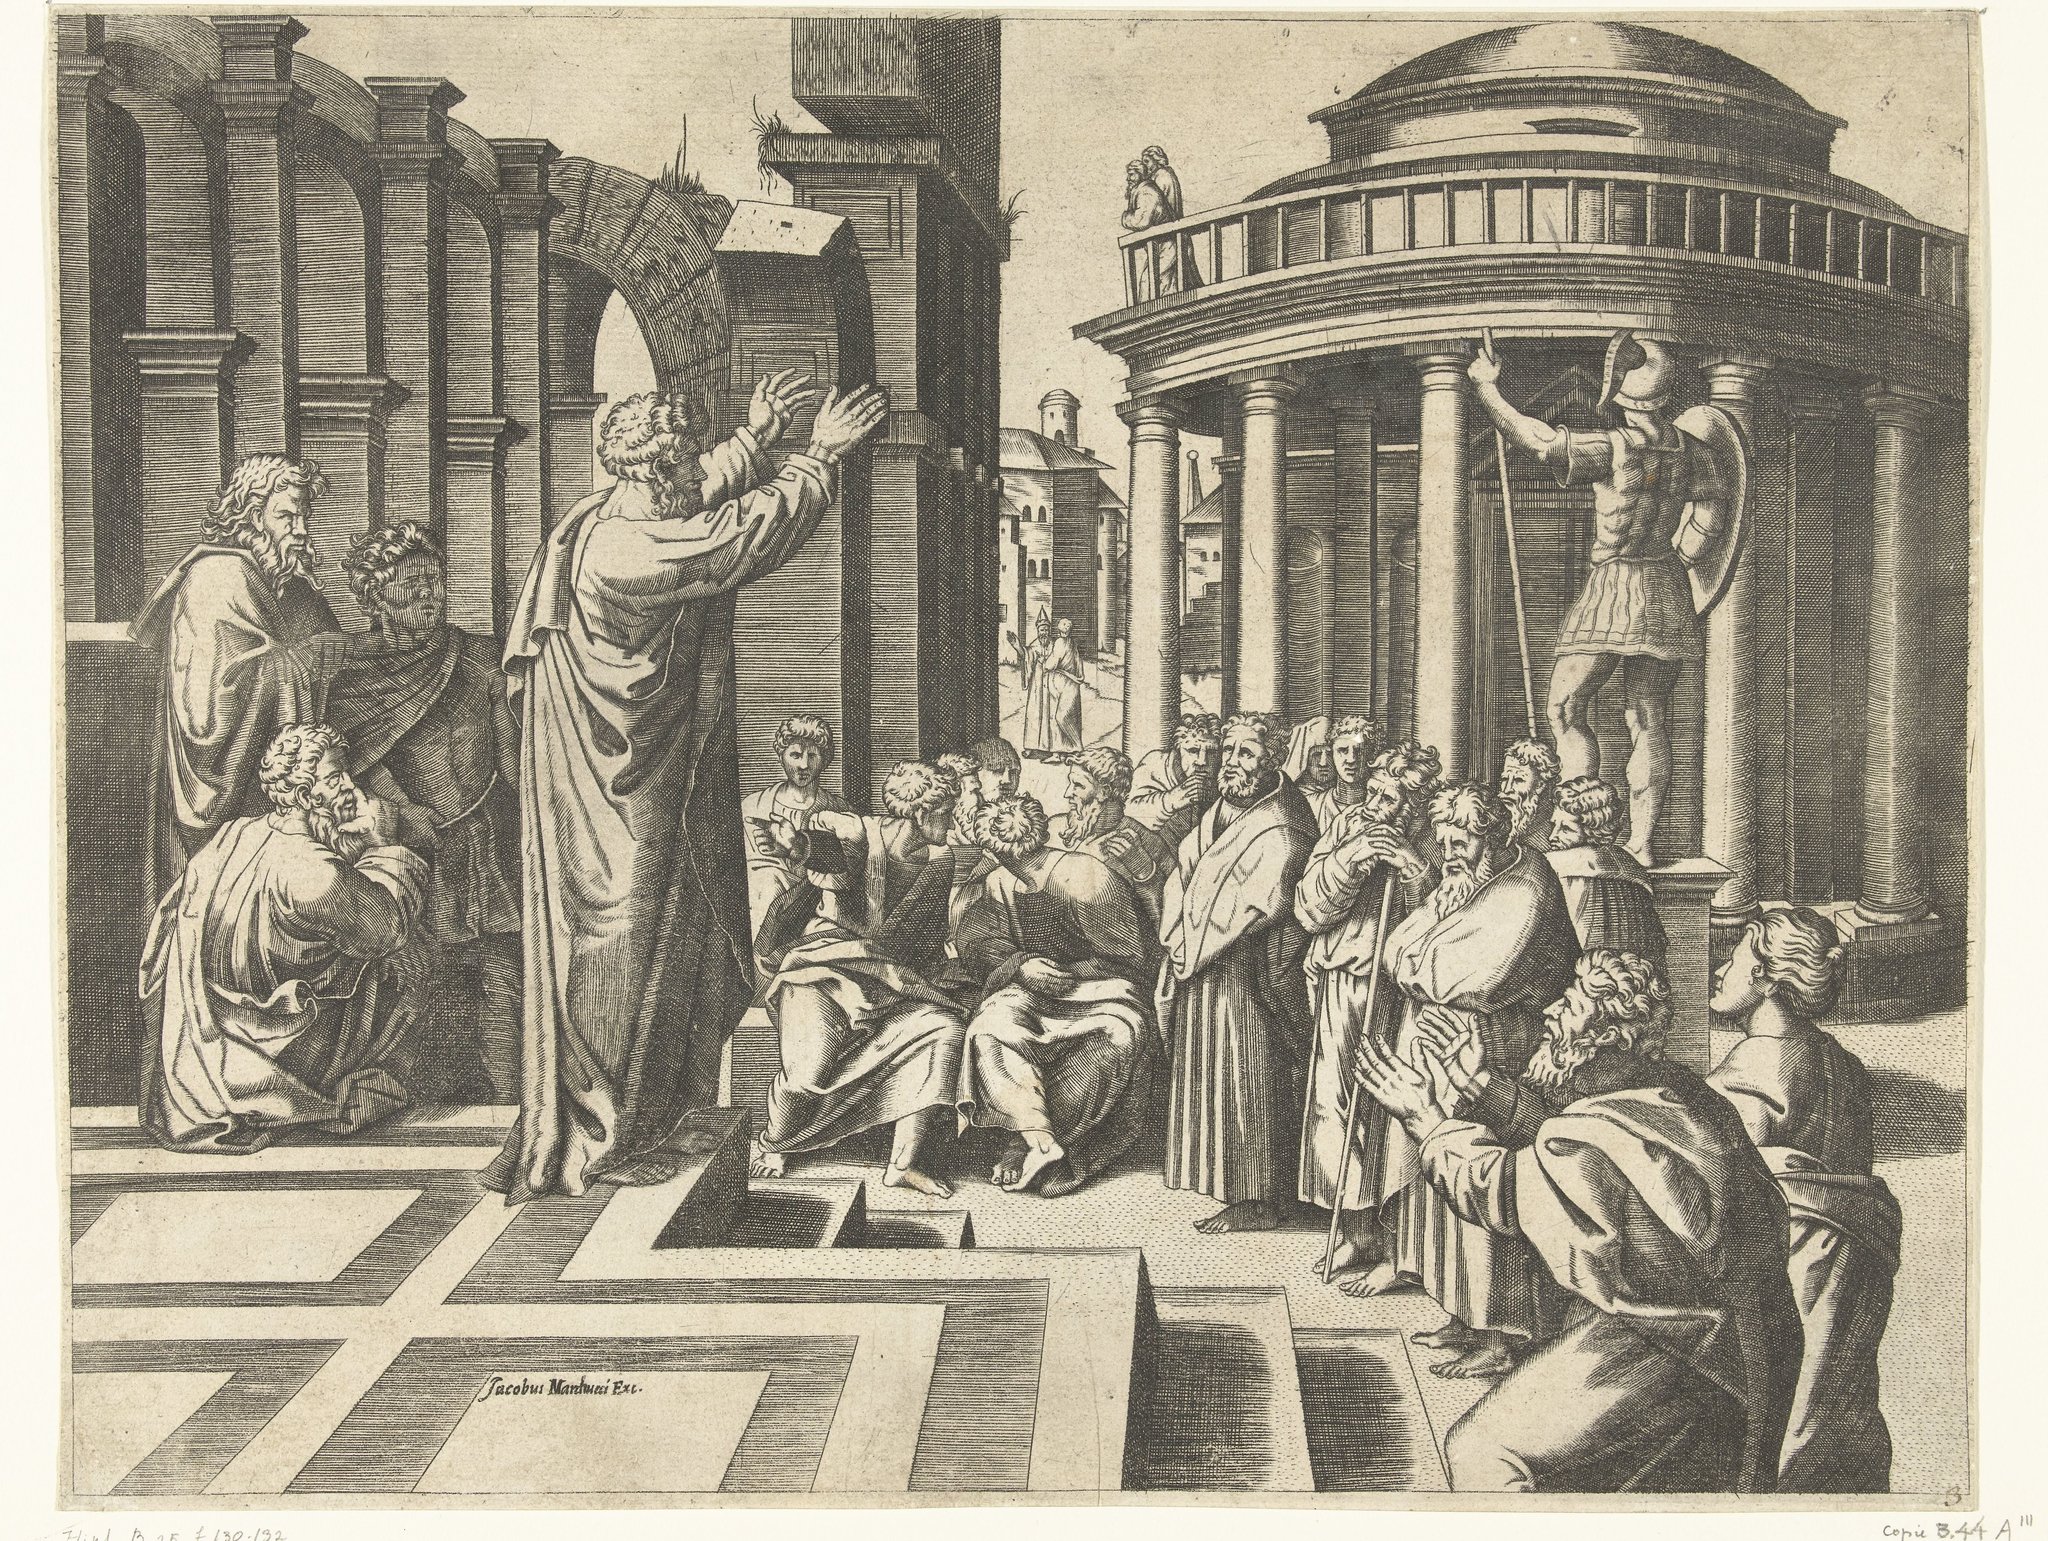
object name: print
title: Paulus predikt in Athene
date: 1517-1628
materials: paper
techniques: engraving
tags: paul in athens: on the areopagus he discusses with philosophers (in front of the temple of mars)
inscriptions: collector's mark: Lugt 10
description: Kopie naar prent van Marcantonio Raimondi. Raimondi baseerde zich op carton met ontwerp voor een tapijt in de Sixtijnse kapel, Rome van Raphael (Shoemaker 1981, p. 152-154).